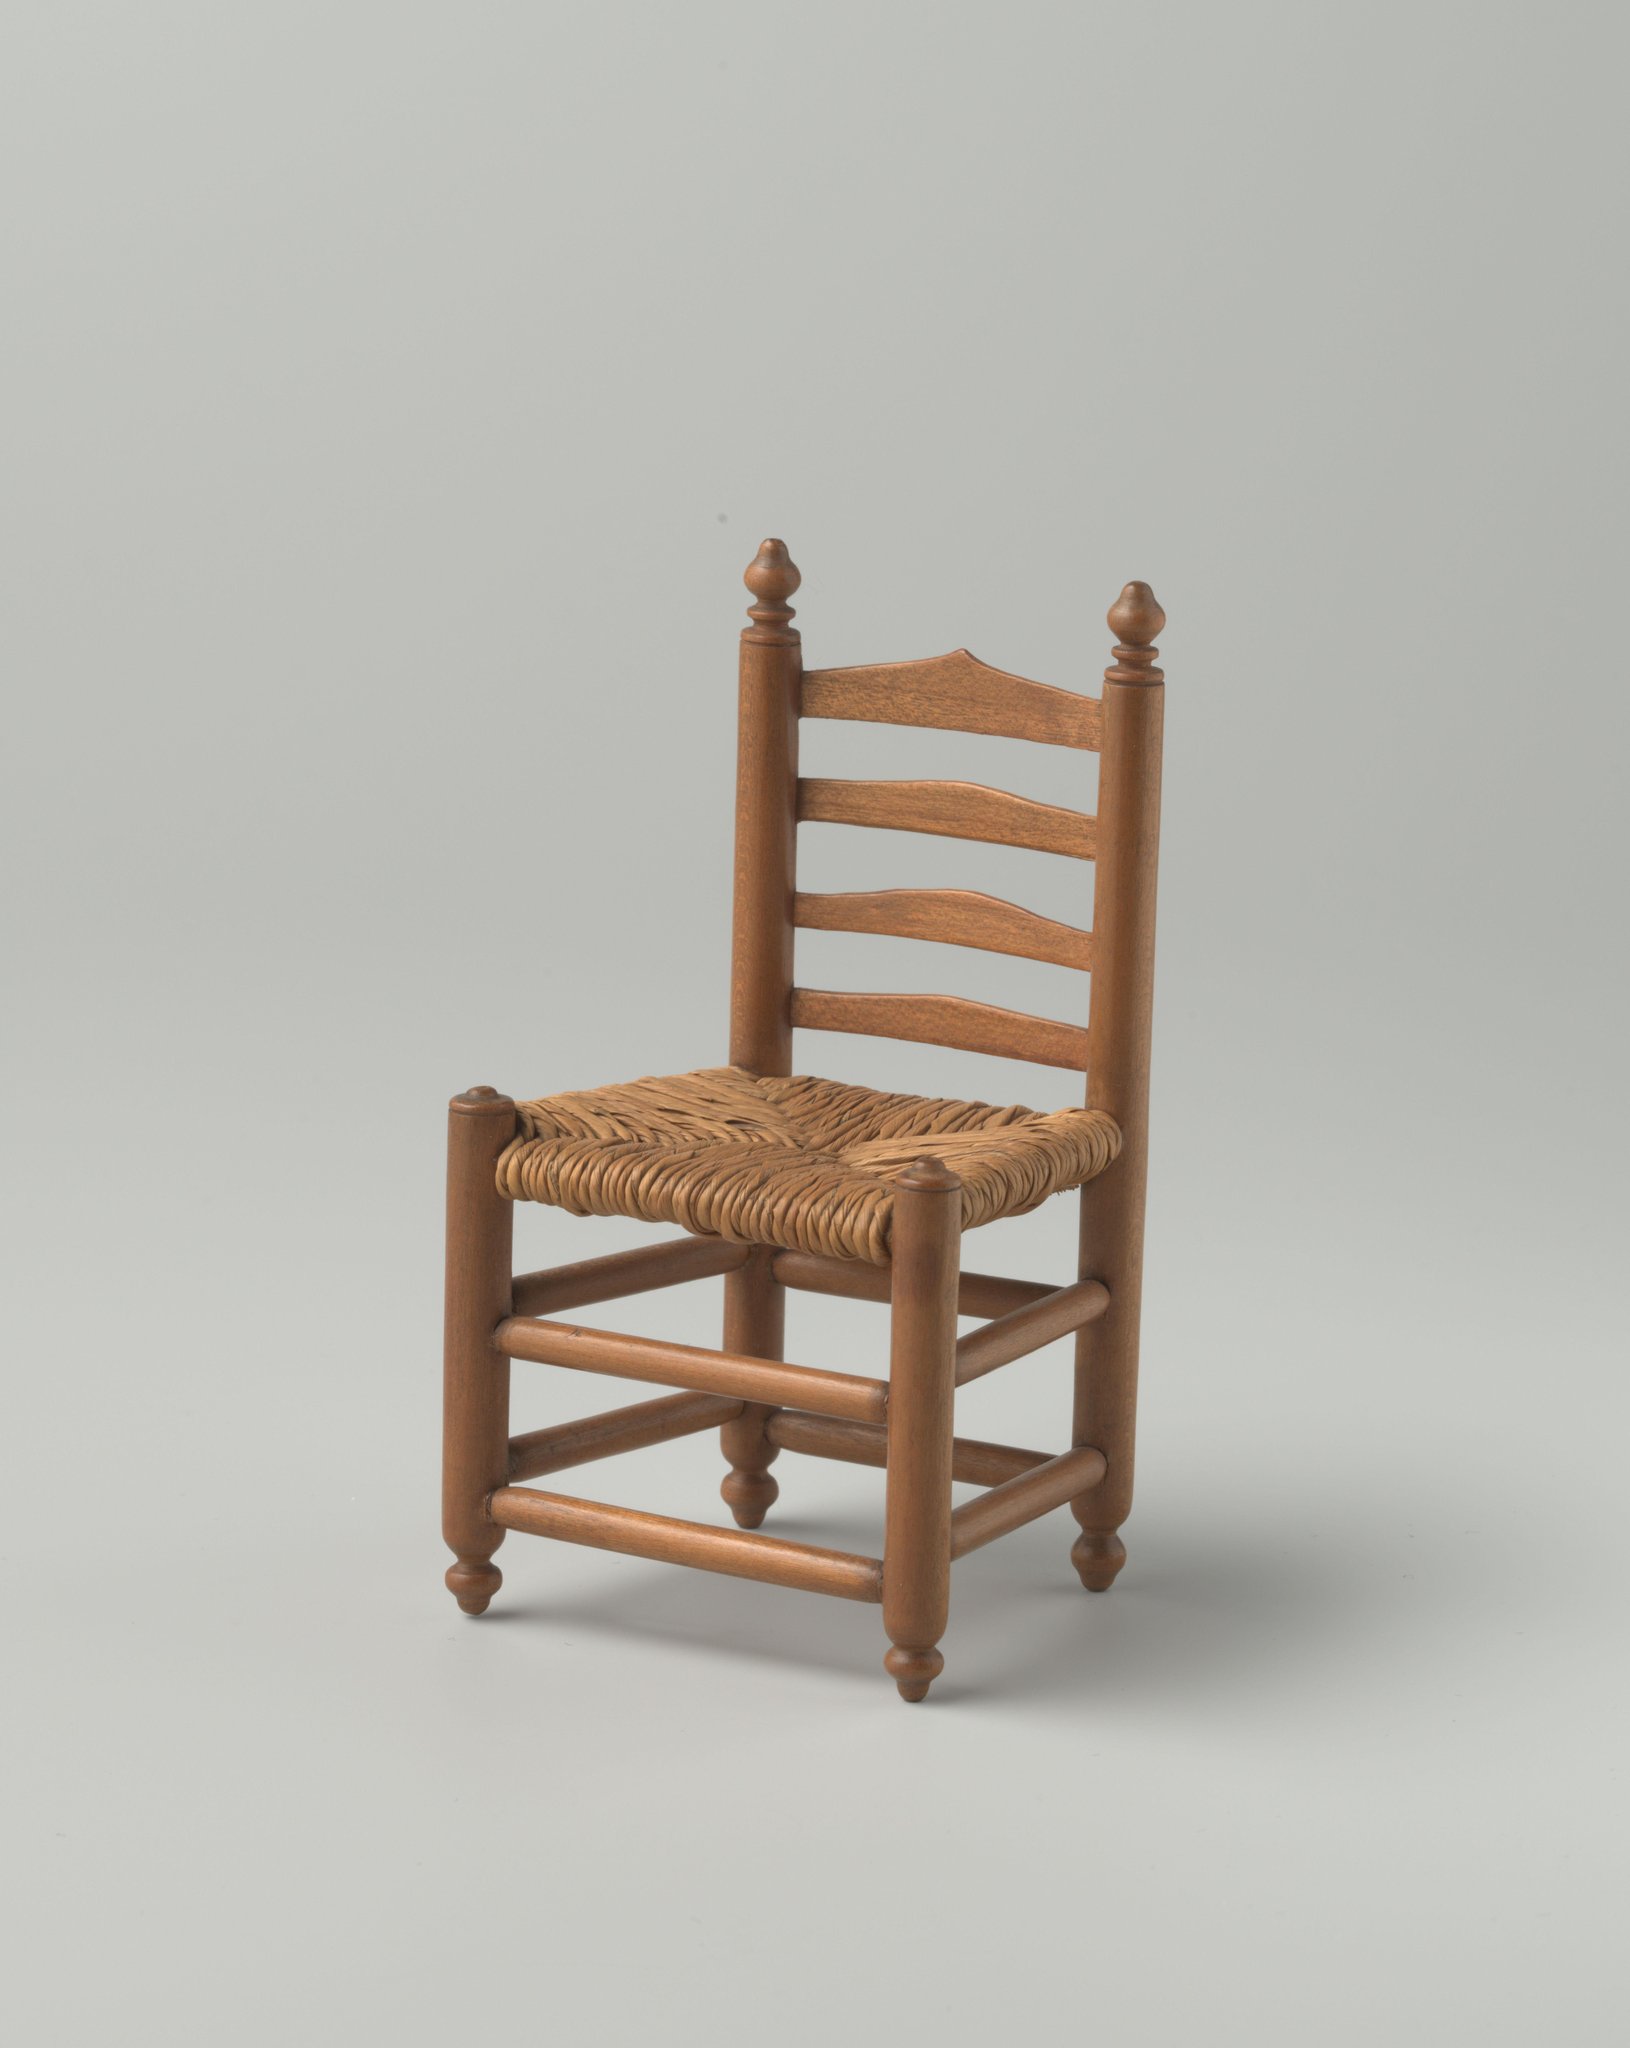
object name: chair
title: Knopstoel vervaardigd van esdoornhout met gladde, gedraaide stijlen en dwarsregels, voorpoten en achterstijlen eindid in fijn gedraaide knoppen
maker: Anonymous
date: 1690-1710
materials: wood, fiber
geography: amsterdam